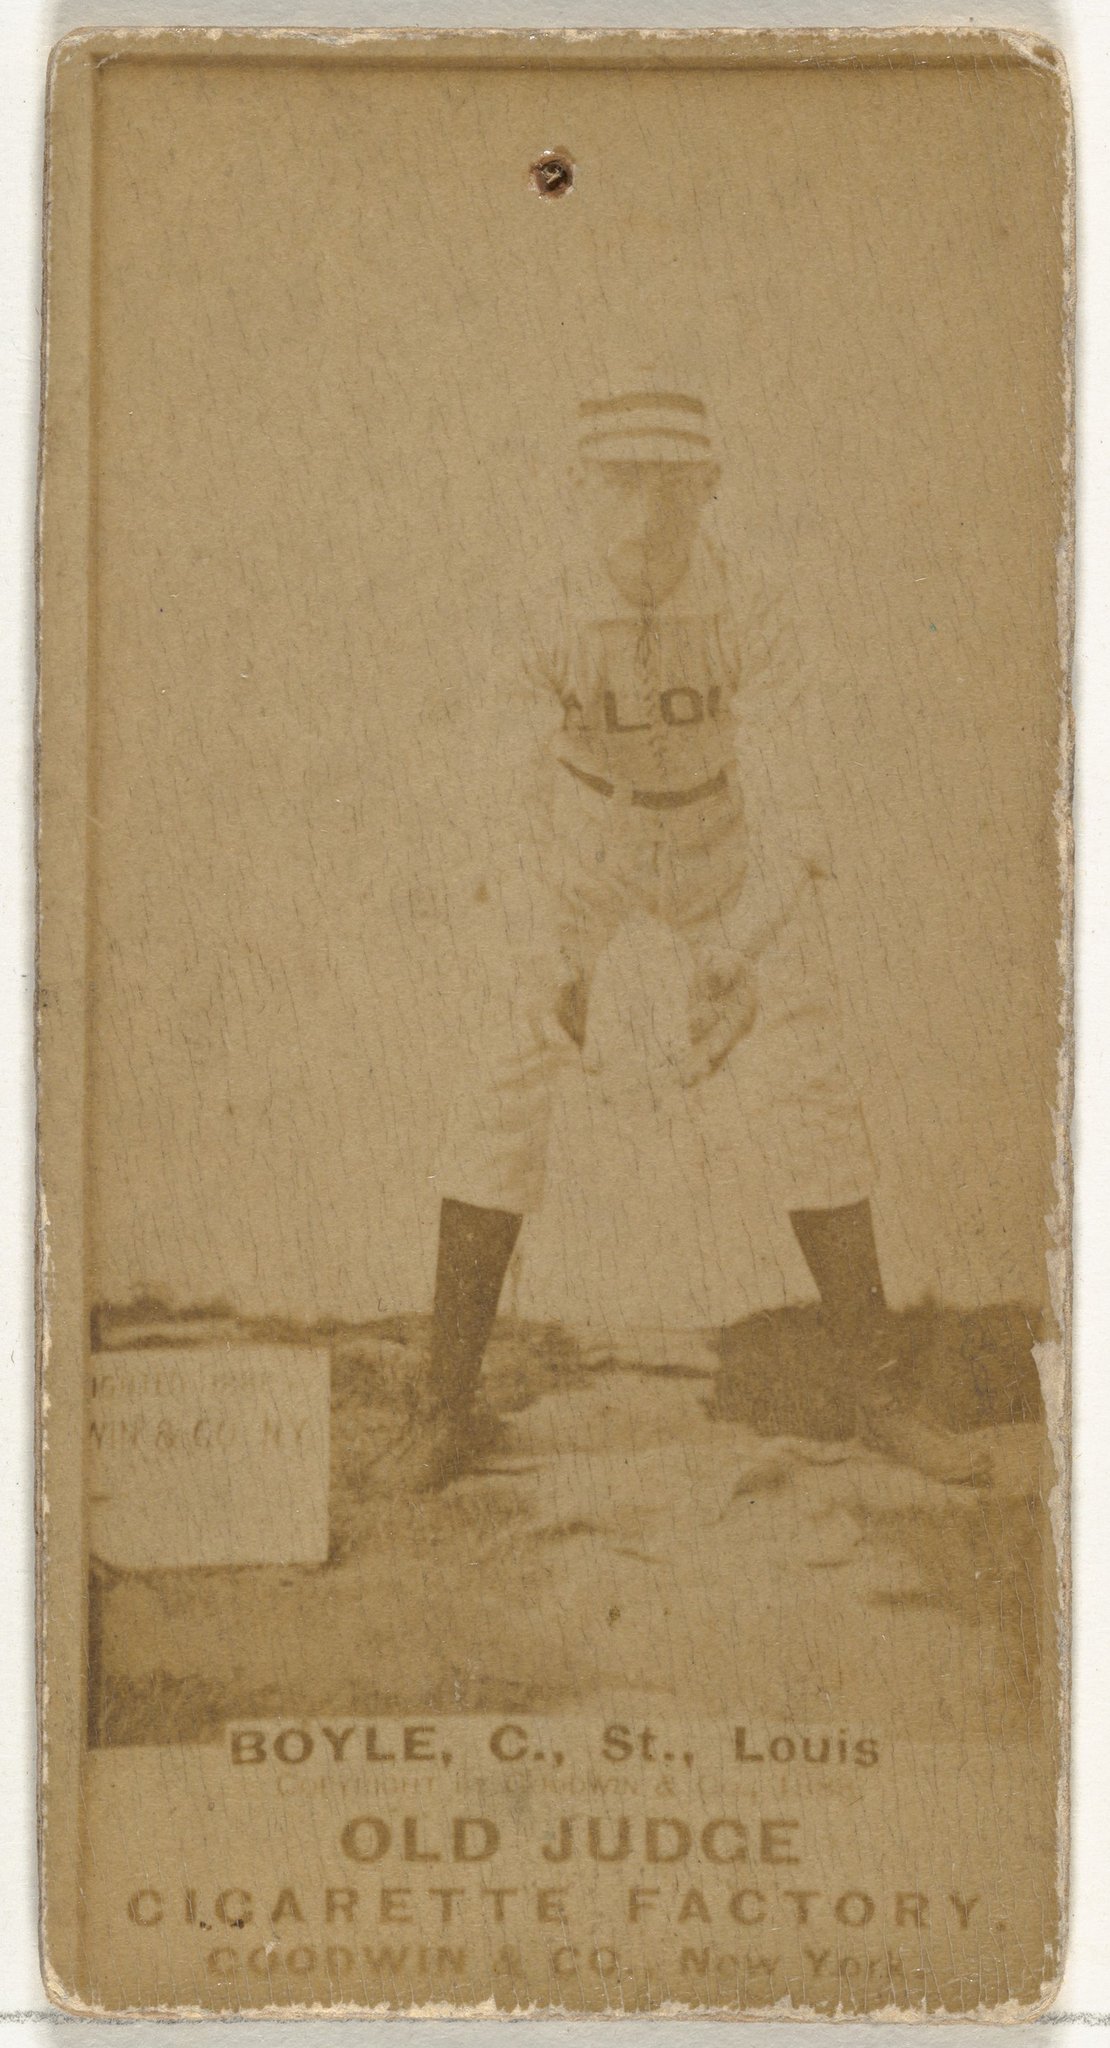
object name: baseball card, photograph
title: John Anthony "Honest John" Boyle, Catcher, St. Louis Browns, from the Old Judge series (N172) for Old Judge Cigarettes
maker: goodwin & company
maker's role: publisher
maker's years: 1850-1950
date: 1887-1890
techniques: albumen silver print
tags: men,portraits,baseball,athletes